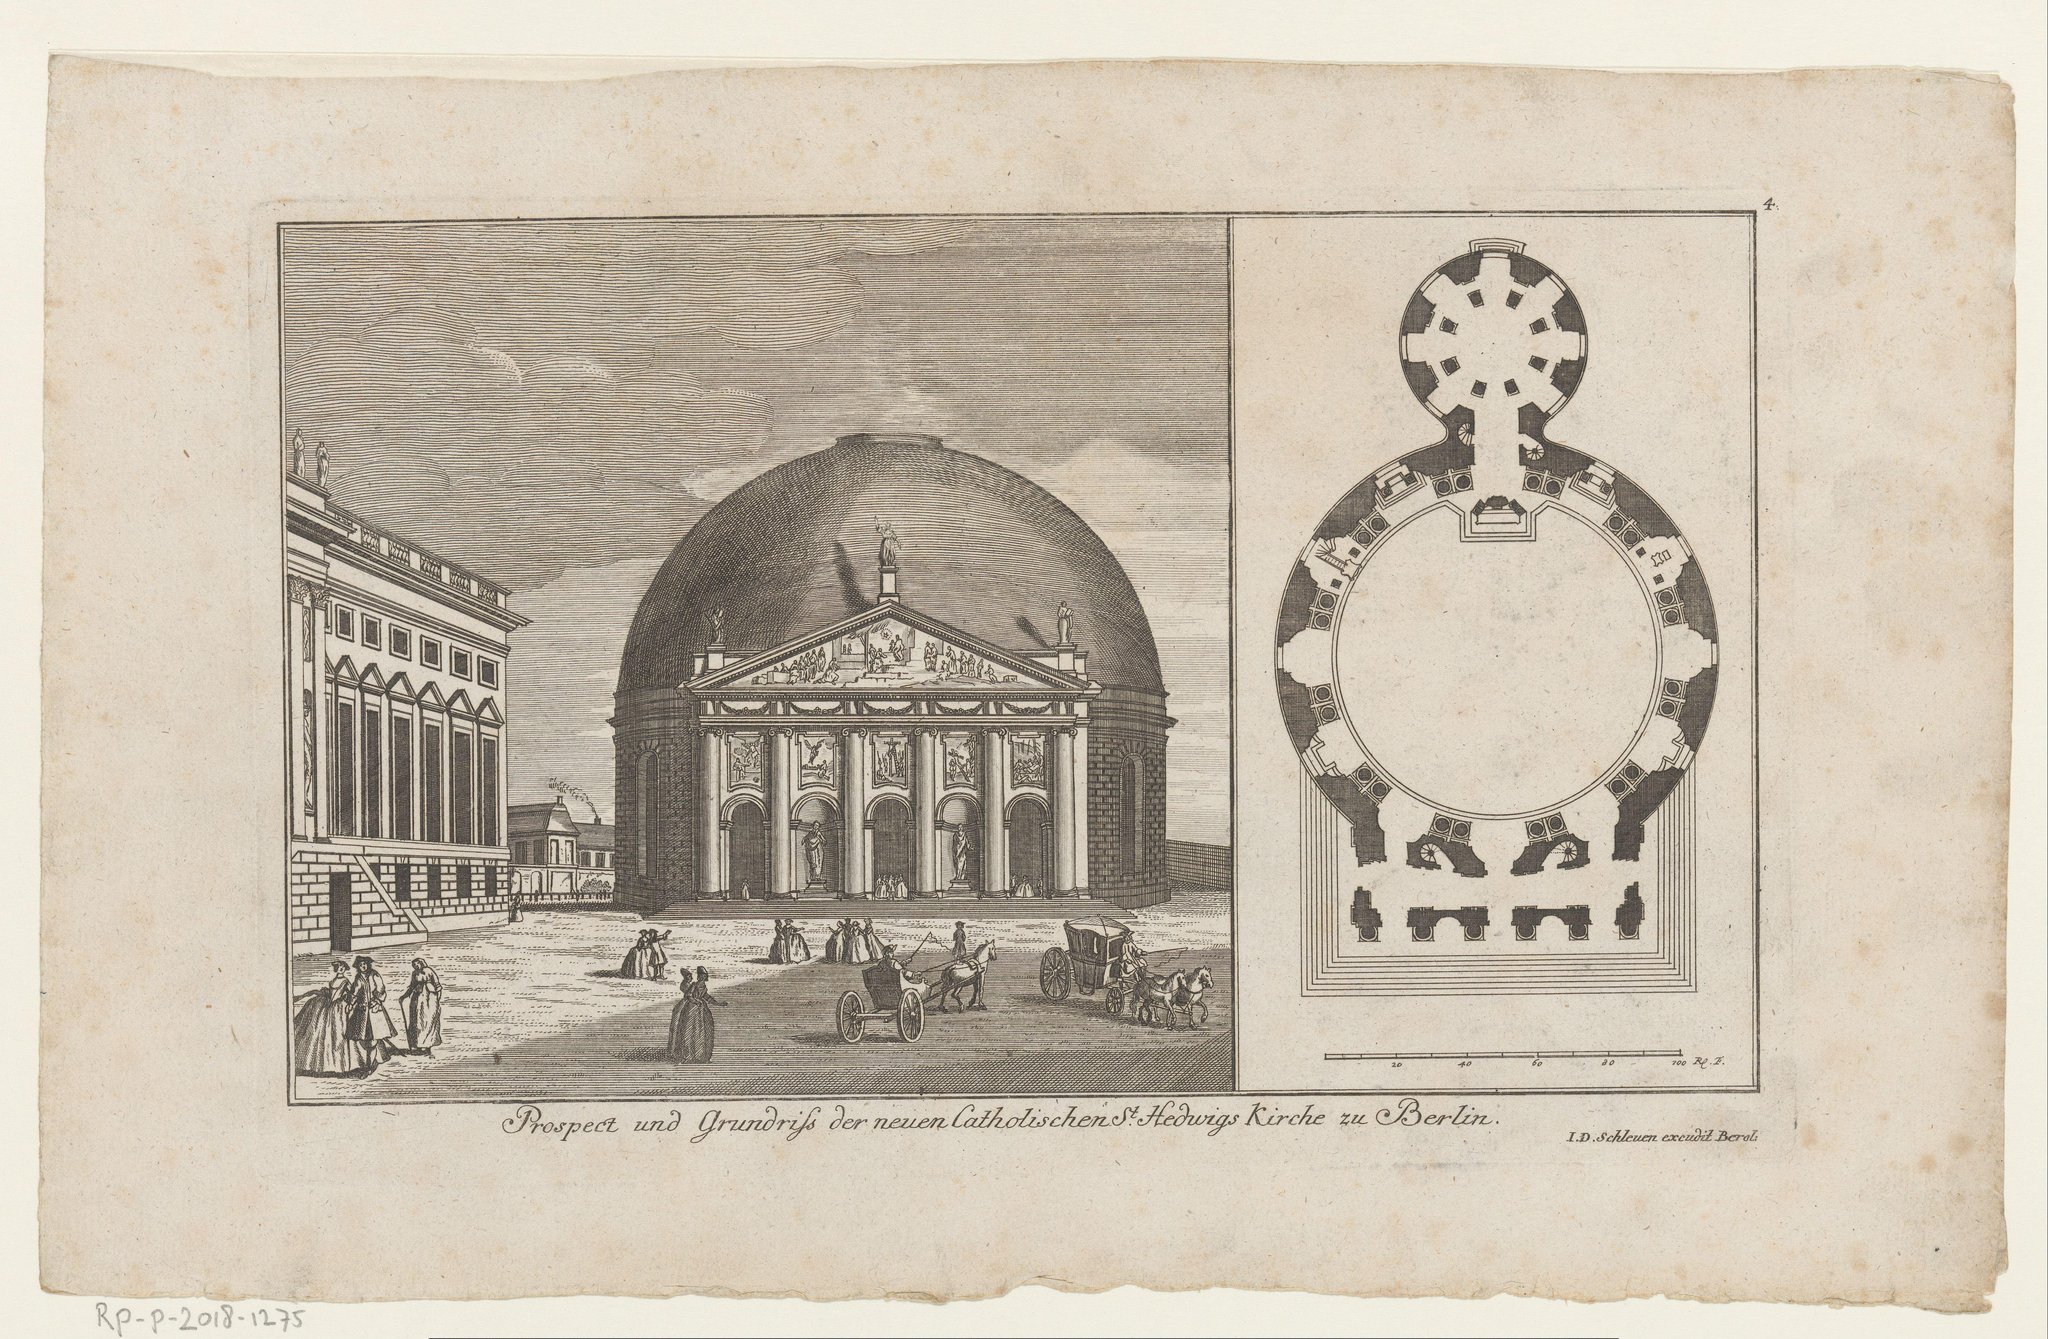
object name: print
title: Prospect und grundriss der neuen catholischen St. Hedwigs Kirche zu Berlin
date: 1740-1774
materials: paper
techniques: engraving, etching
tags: church (exterior), plan ~ architecture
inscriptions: collector's mark: Lugt 2228